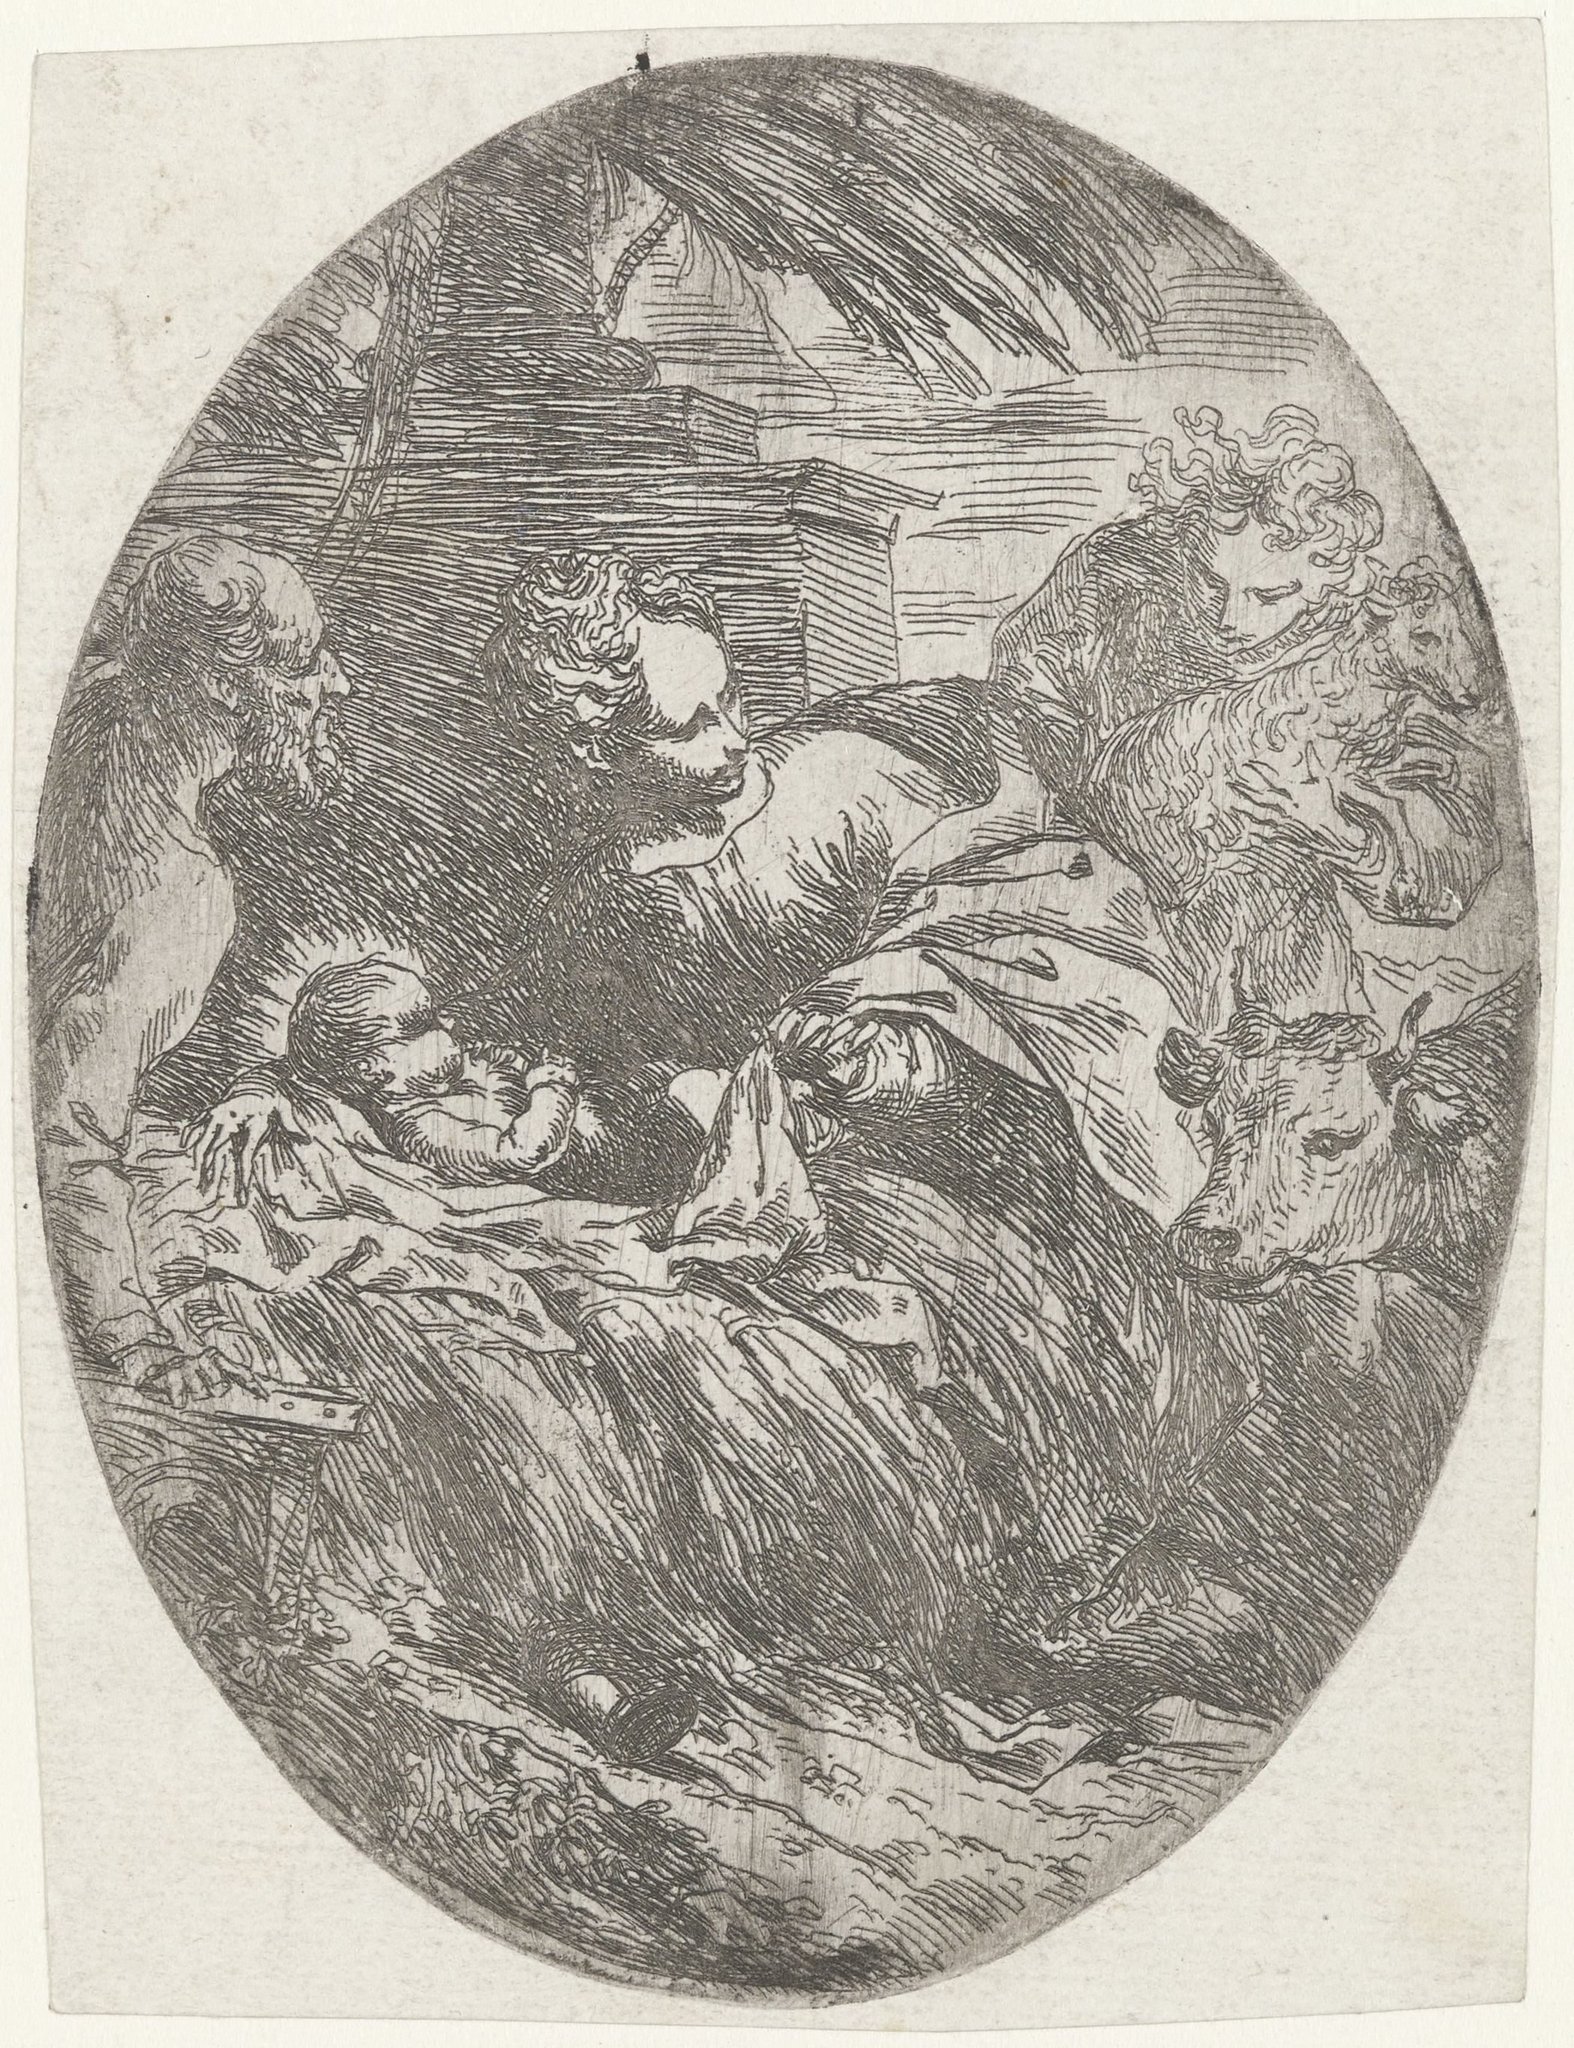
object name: print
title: Geboorte van Christus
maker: bartolomeo biscaino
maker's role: print maker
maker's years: 1632-1657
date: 1642-1657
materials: paper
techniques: etching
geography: italy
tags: mary, joseph and the new-born christ (nativity)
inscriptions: collector's mark: Lugt 2760, collector's mark: Lugt 2228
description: Maria en Jozef met het Christuskind in een stal. Op de achtergrond een herder met een os en een lam.